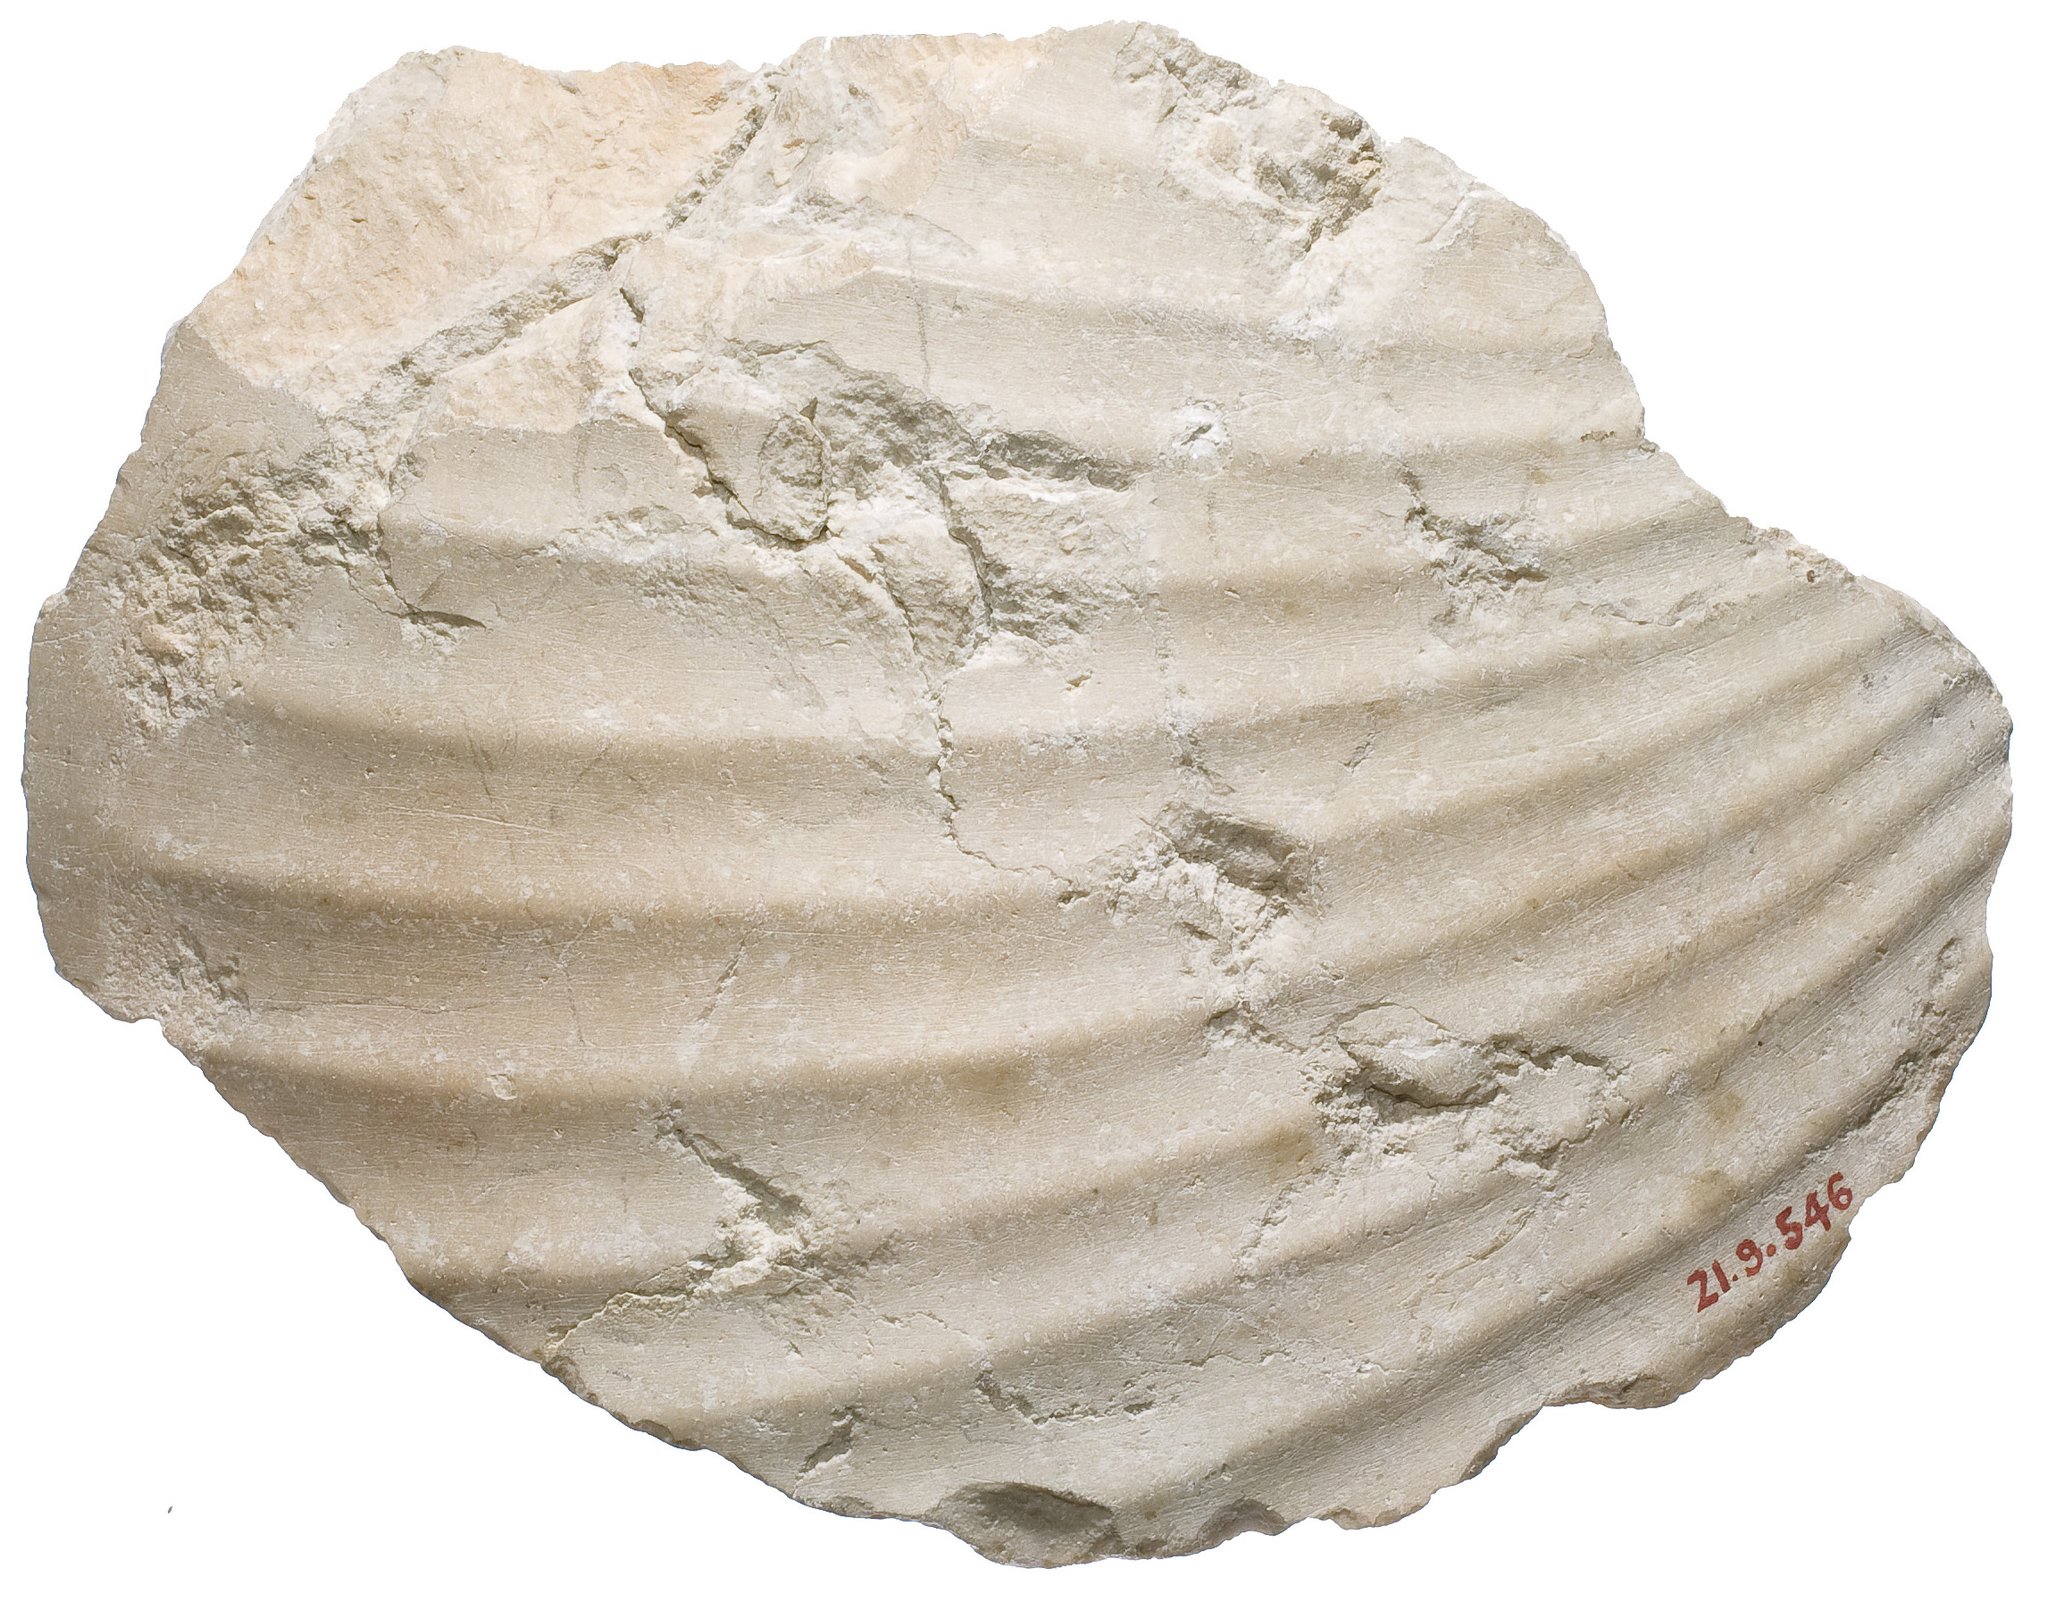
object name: garment fragment, male, gather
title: Kilt gathers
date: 1353-1336 BCE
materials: limestone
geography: egypt